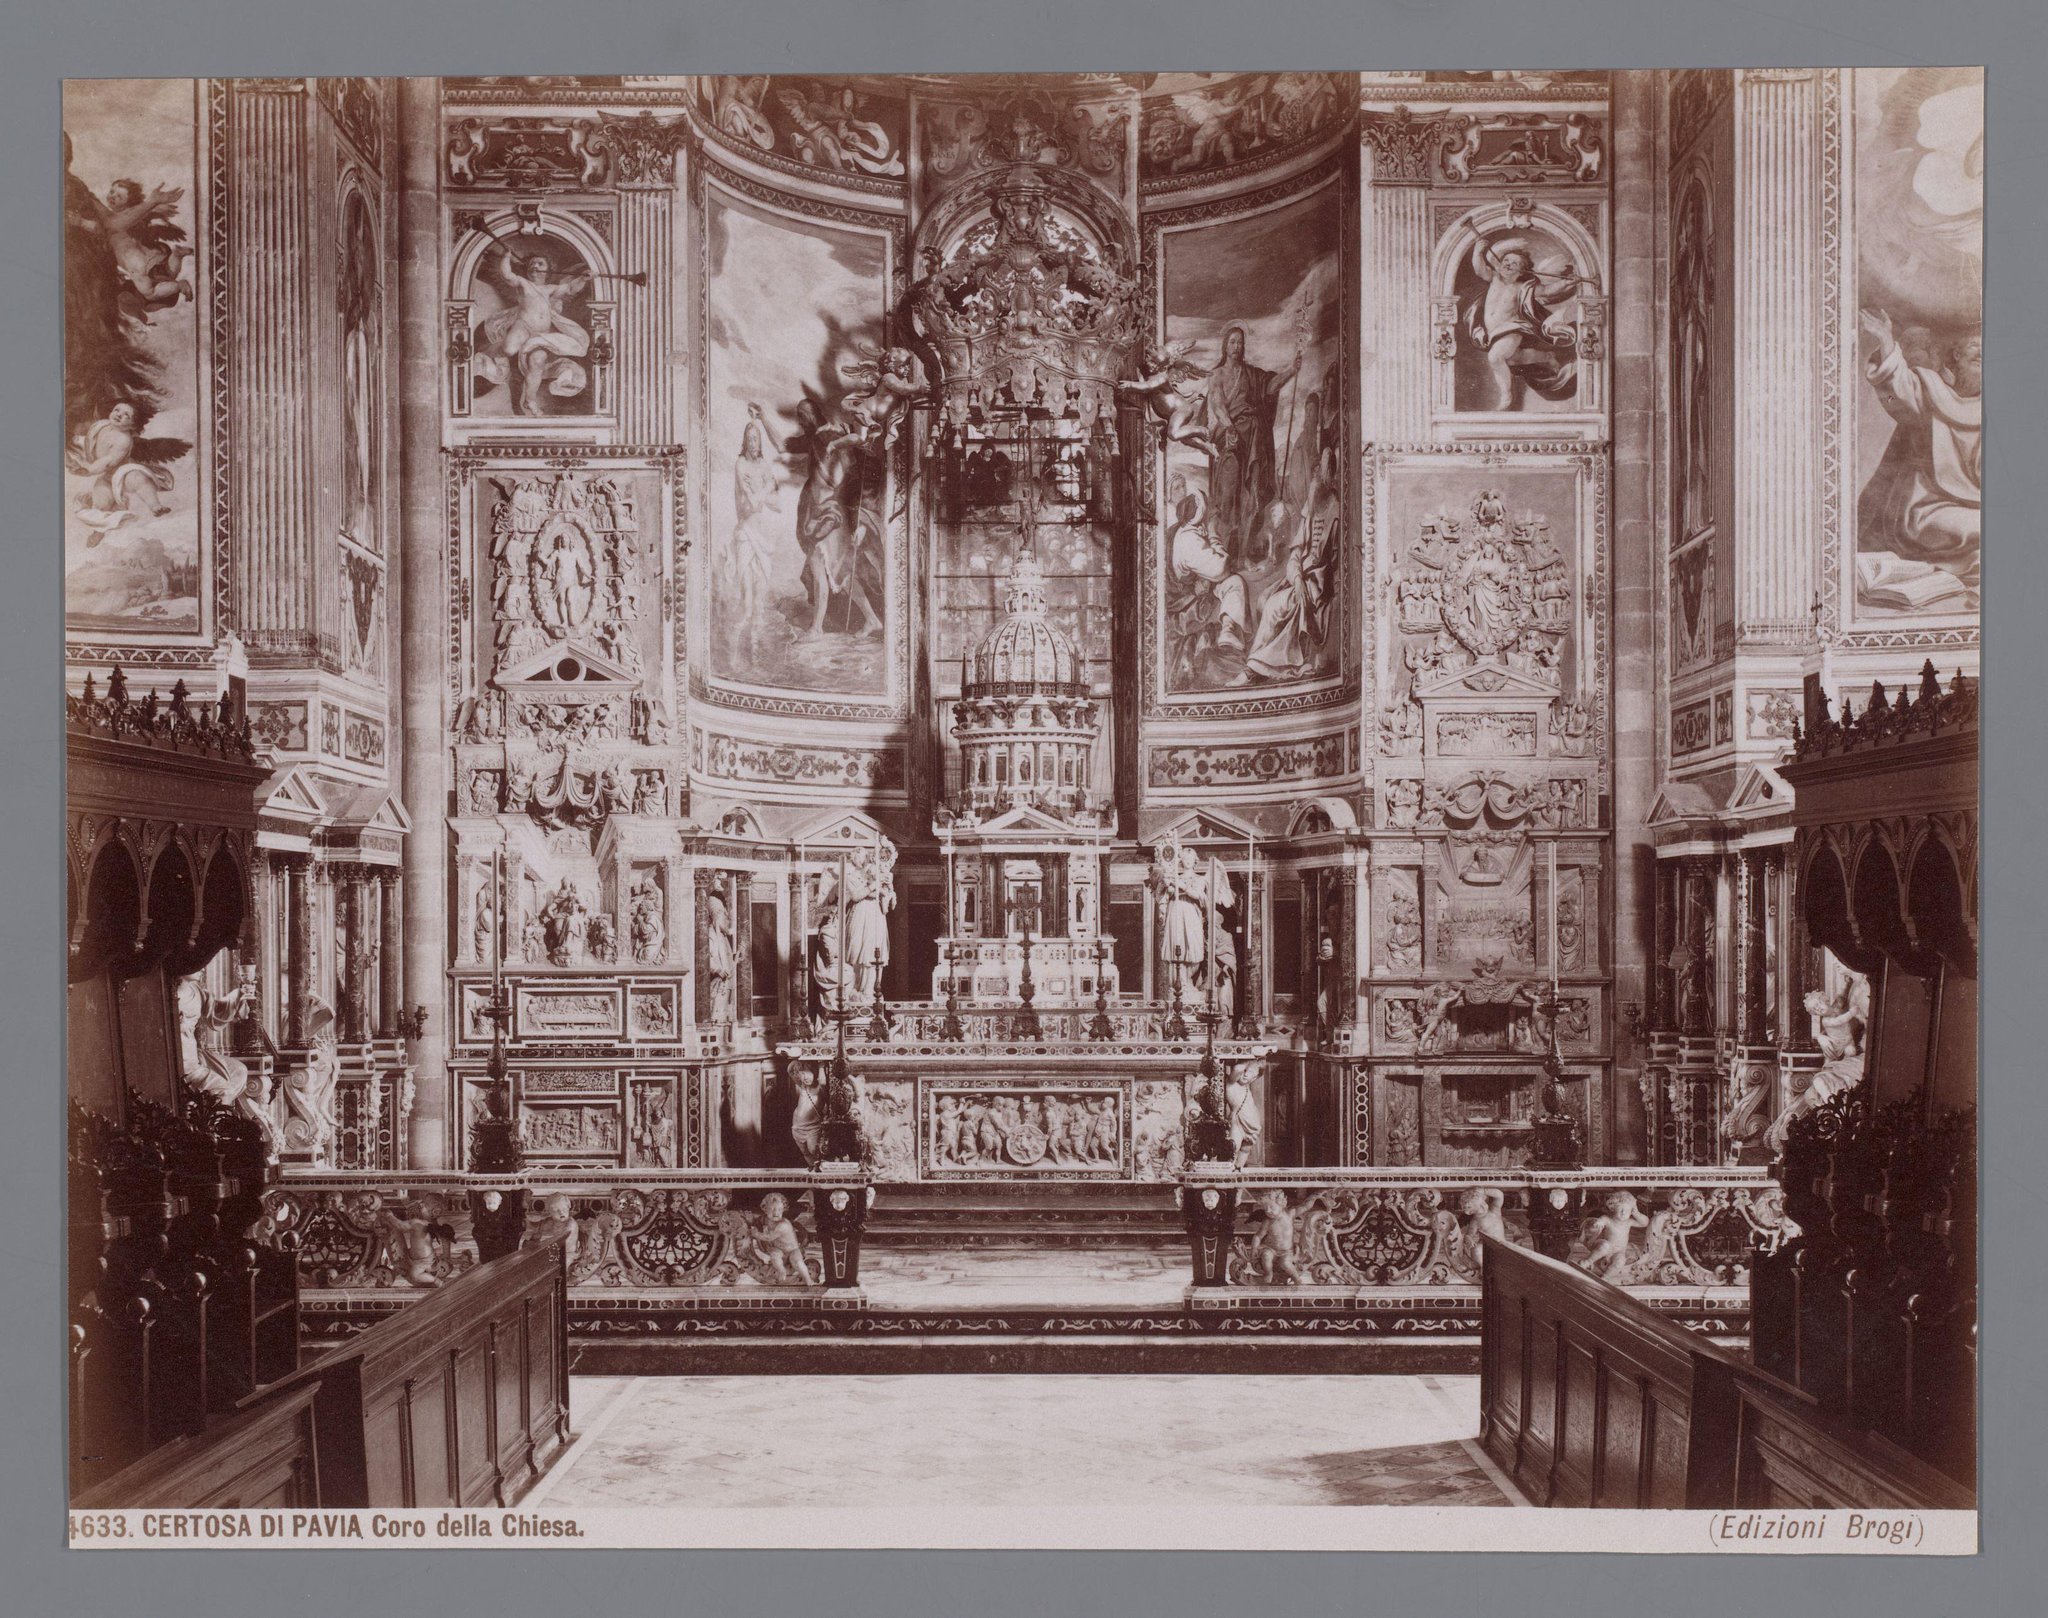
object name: photograph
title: Certosa di Pavia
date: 1856-1881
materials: cardboard, paper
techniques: albumen print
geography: pavia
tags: parts of church interior: choir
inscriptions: number: ‘1633.’, number: ‘13’